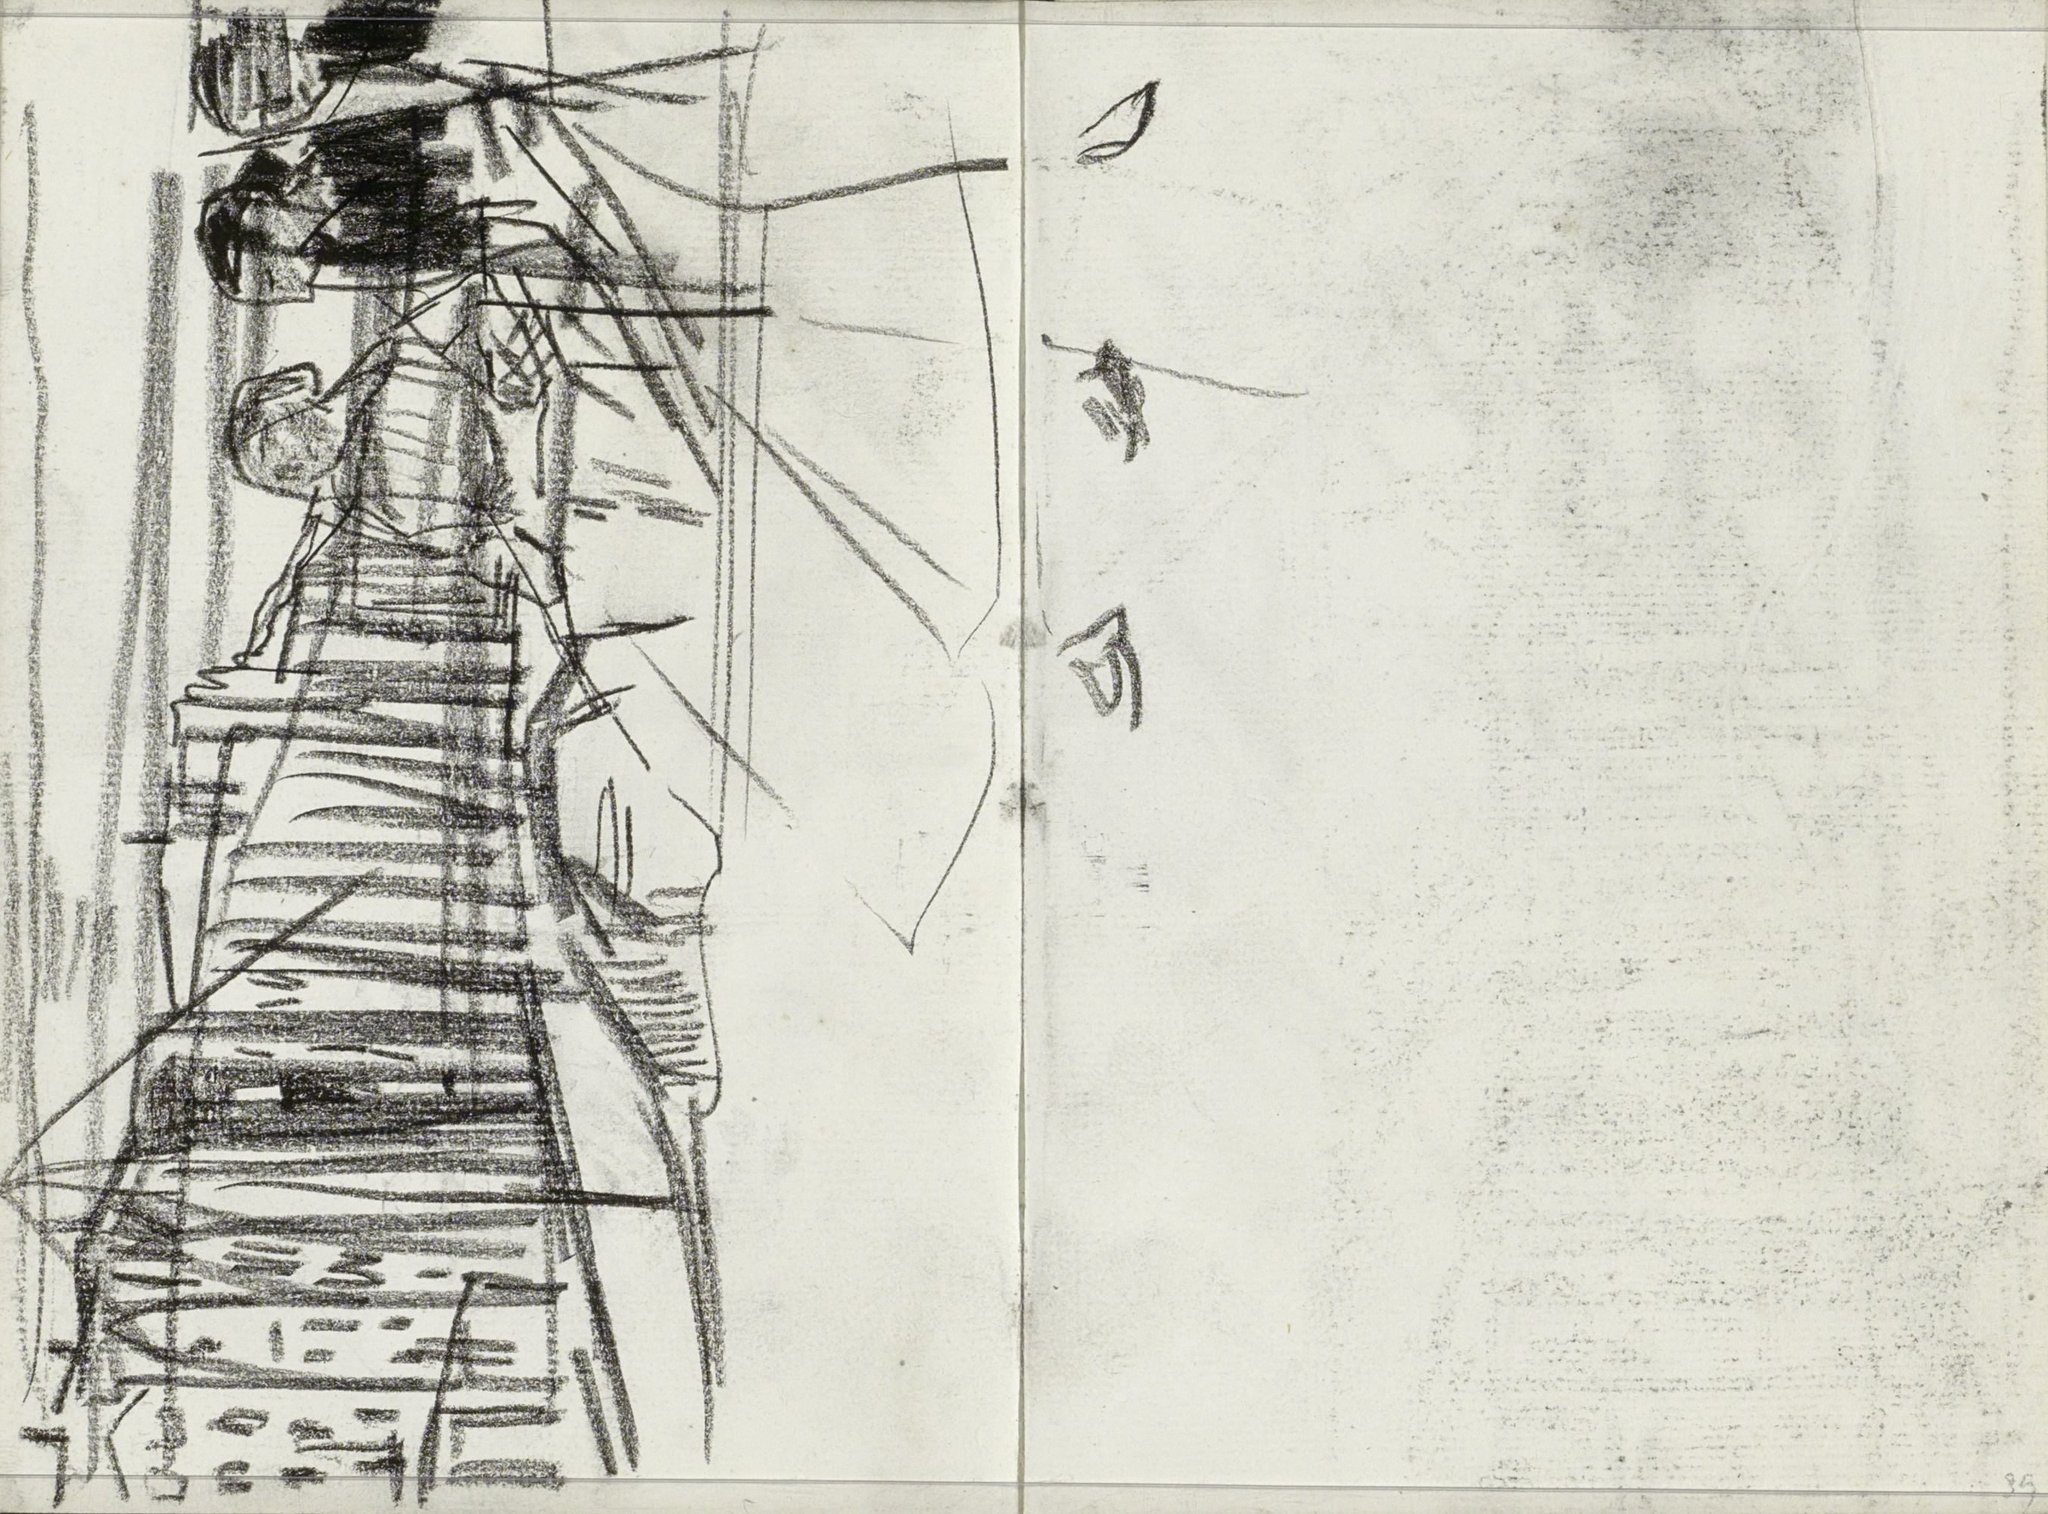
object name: sketchbook leaf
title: Drie vrouwen op een gracht, mogelijk de Prinsengracht te Amsterdam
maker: isaac israels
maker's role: draughtsman, painter, print maker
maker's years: 1865-1934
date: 1886-1903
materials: chalk, paper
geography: amsterdam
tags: adult woman, street (+ city(-scape) with figures, staffage)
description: Pagina 38 en pagina 39 uit schetsboek XXXVII met 52 pagina's.